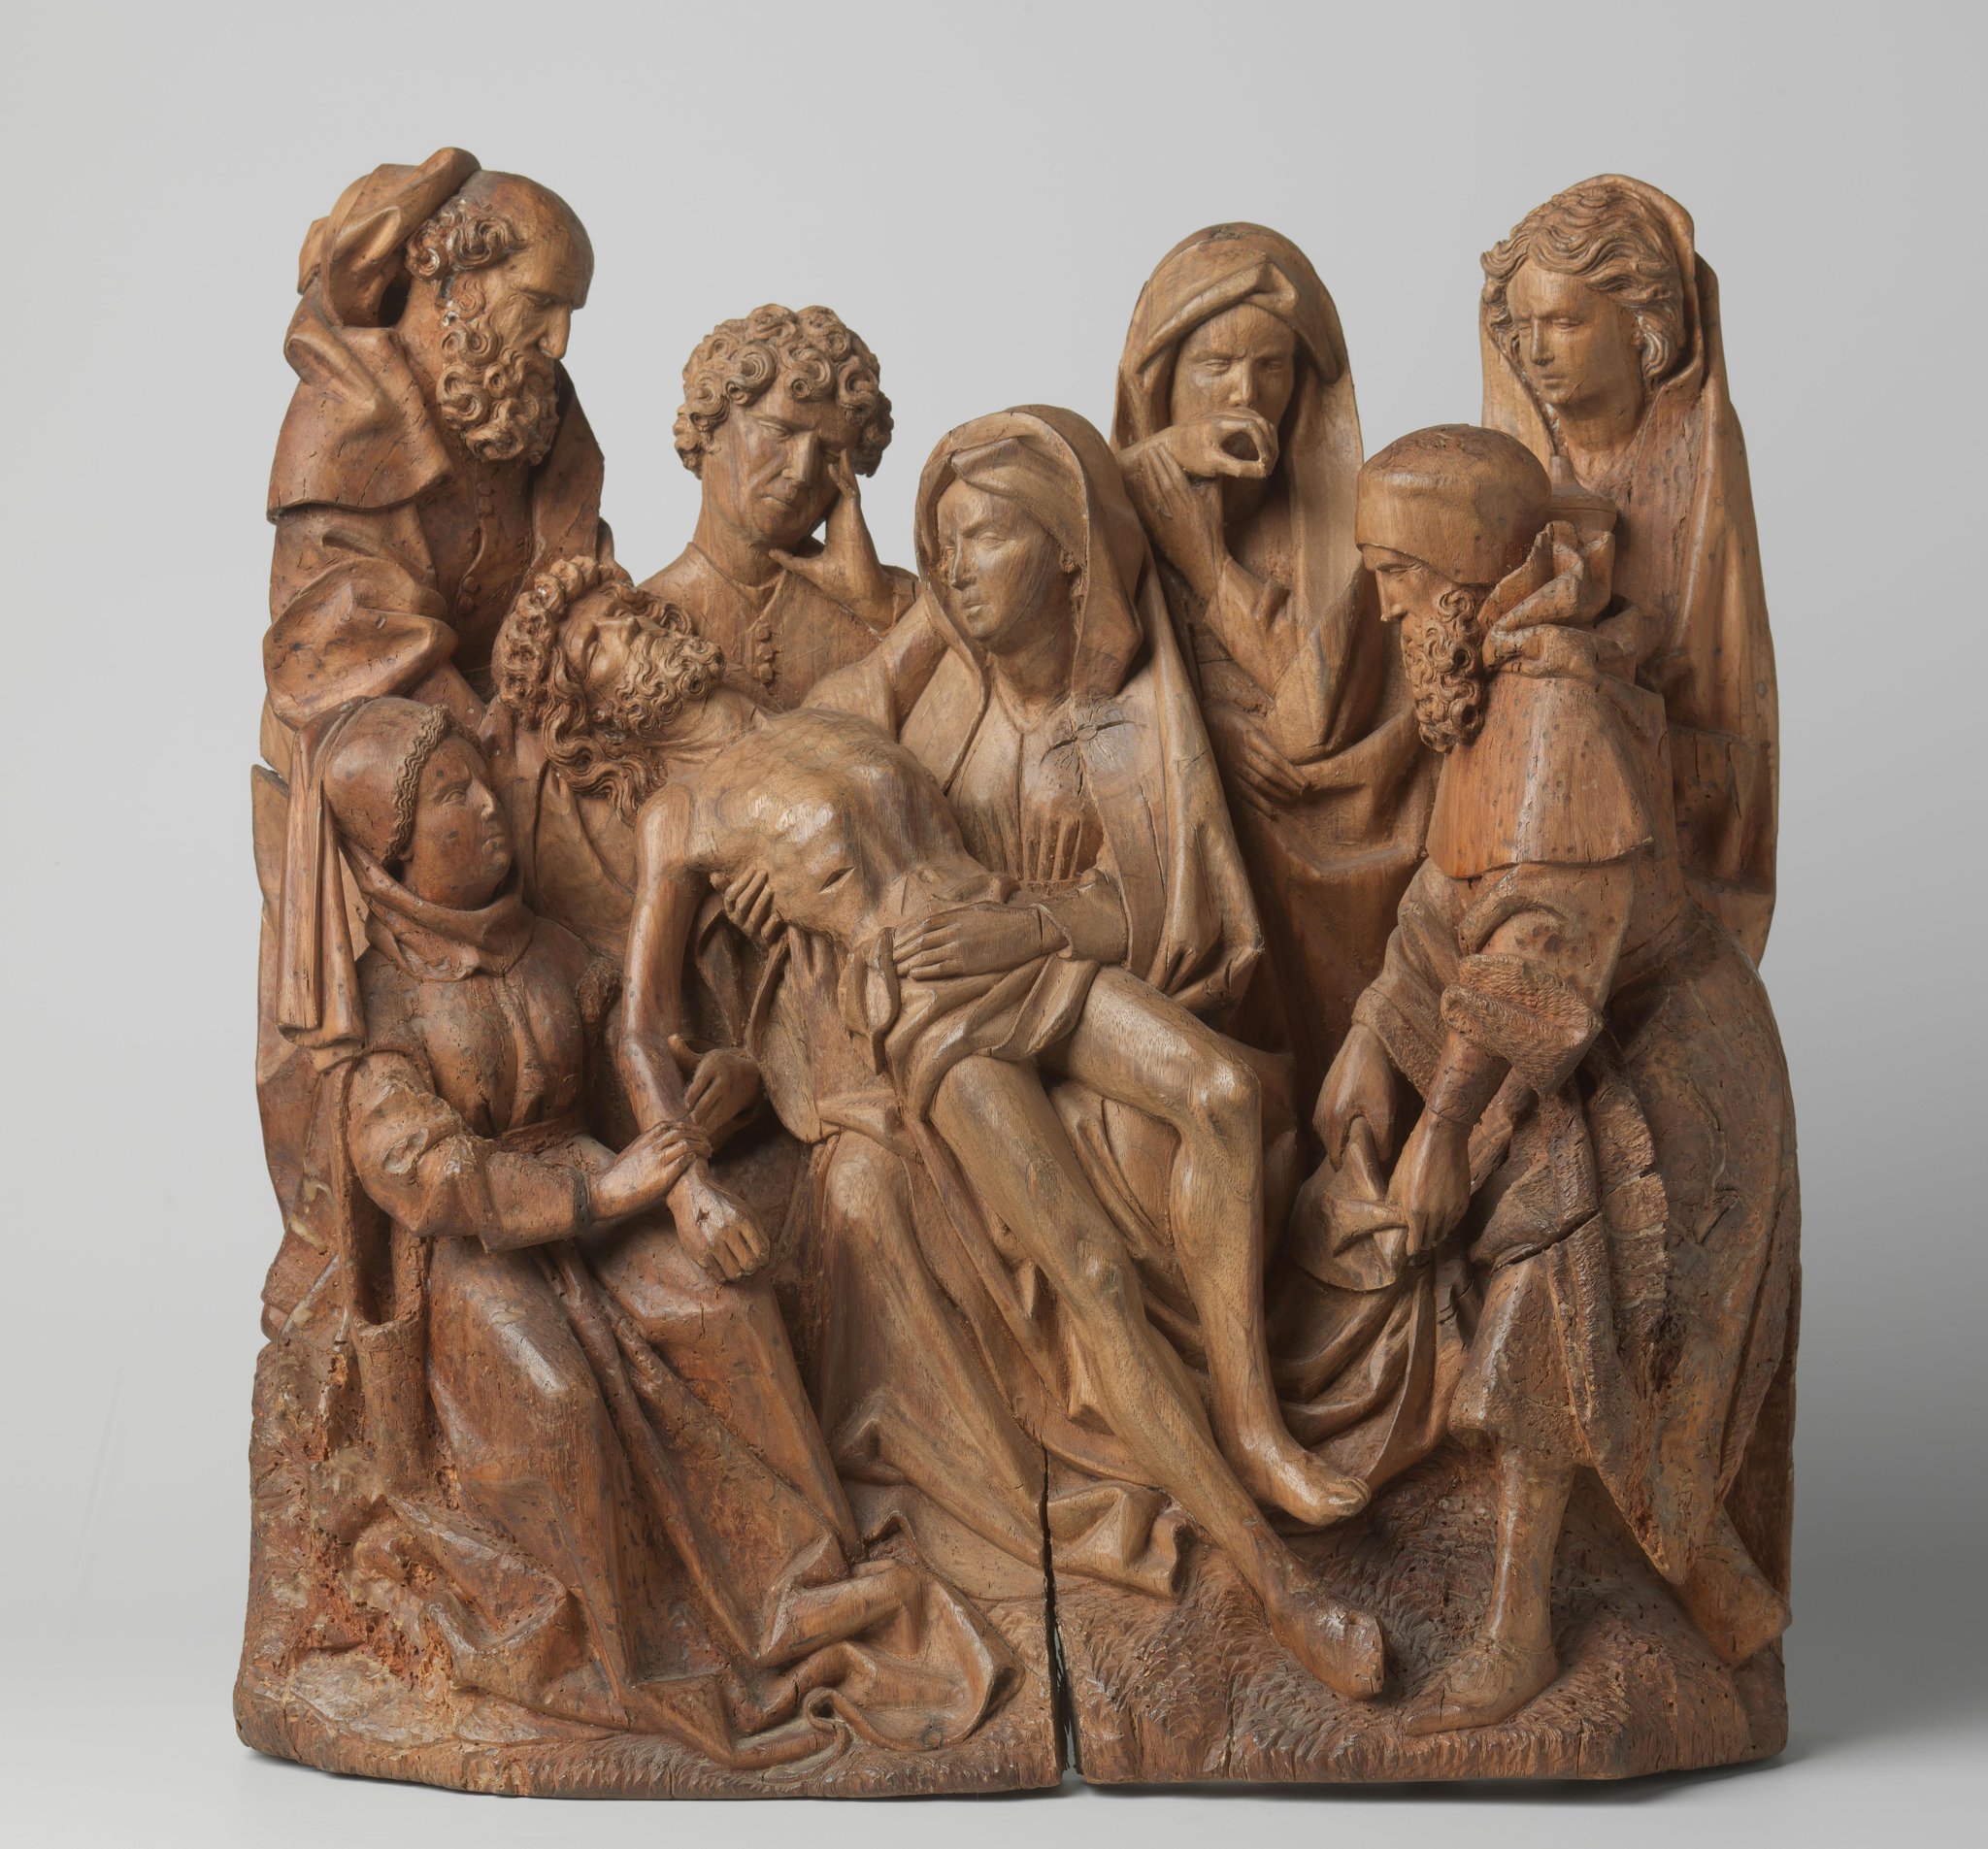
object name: sculpture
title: The Lamentation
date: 1440-1450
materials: wood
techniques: polychromy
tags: descent from the cross: christ is taken down from the cross, usually by nicodemus and joseph of arimathaea who are standing on the ladders (both arms of christ detached), christ's body supported by mary, others present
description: The lifeless body of Christ rests on the lap of his mother Mary. She is surrounded by a group of faithful followers, including the Apostle John at the left behind her. The sculptural ensemble was part of a large, now lost Passion altarpiece from the Southern Netherlands. Typically, sculptures from that area were made of walnut and featured a dramatic emotionalism.